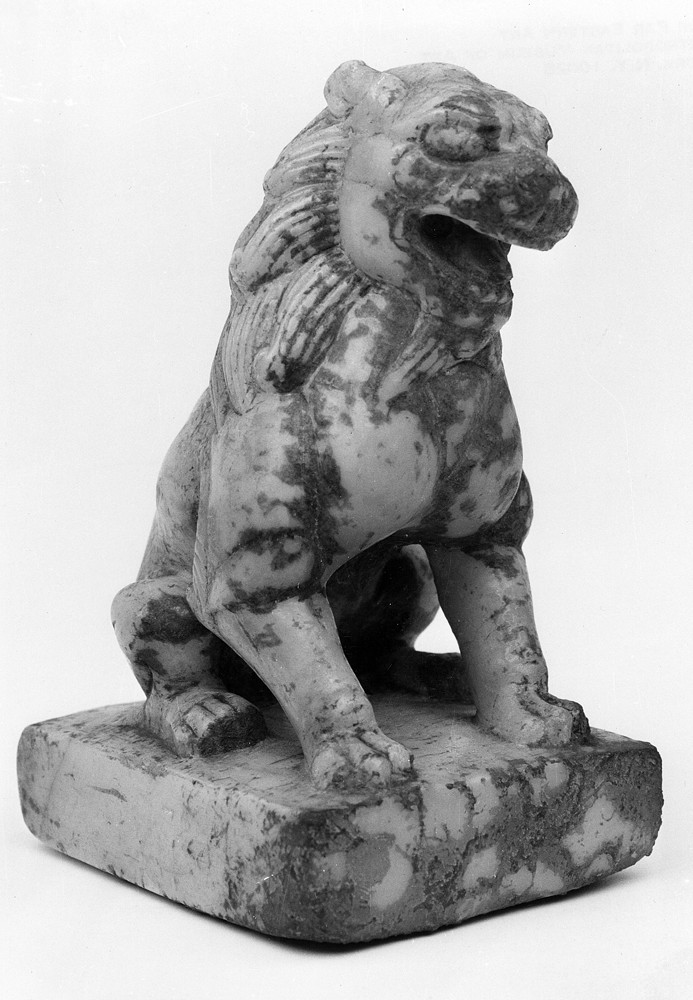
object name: statuette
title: Seated Lion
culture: chinese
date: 618-907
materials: marble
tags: lions